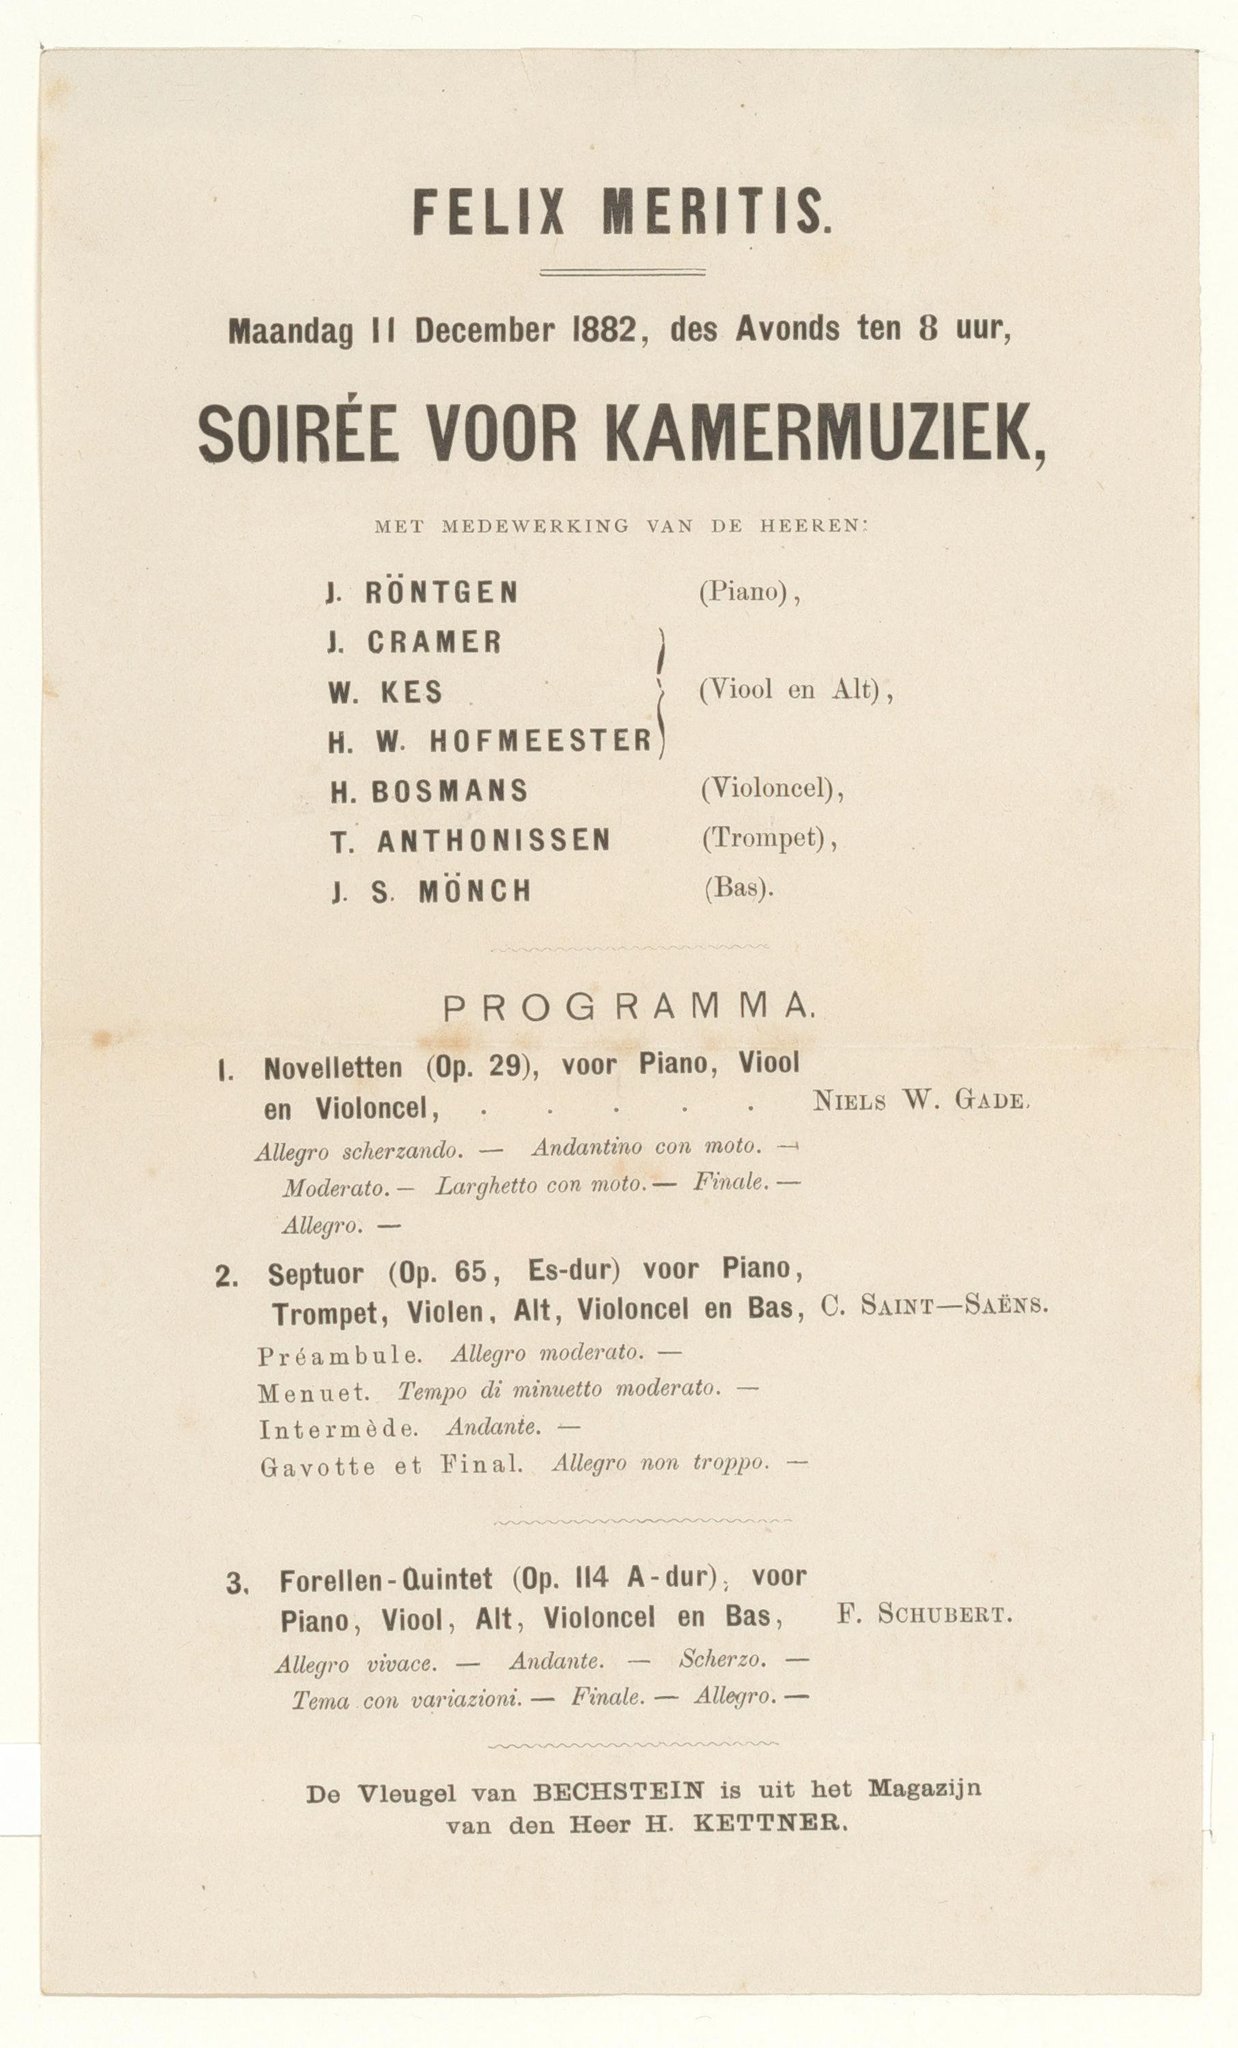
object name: programma, programmaboekje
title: Programma voor een concert in Felix Meritis op 11 december 1882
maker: Anonymous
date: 1882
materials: paper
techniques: letterpress printing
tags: small group of musicians, chamber orchestra, jazz band, listening to music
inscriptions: collector's mark, collector's mark: Lugt 1641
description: Gedrukt programma voor een soirée met kamermuziek, in Felix Meritis te Amsterdam op 11 december 1882. Onderwerpsrubrieken binnen de Atlas Zeden en Gewoonten: Muziek en muziekinstrumenten: Varia.